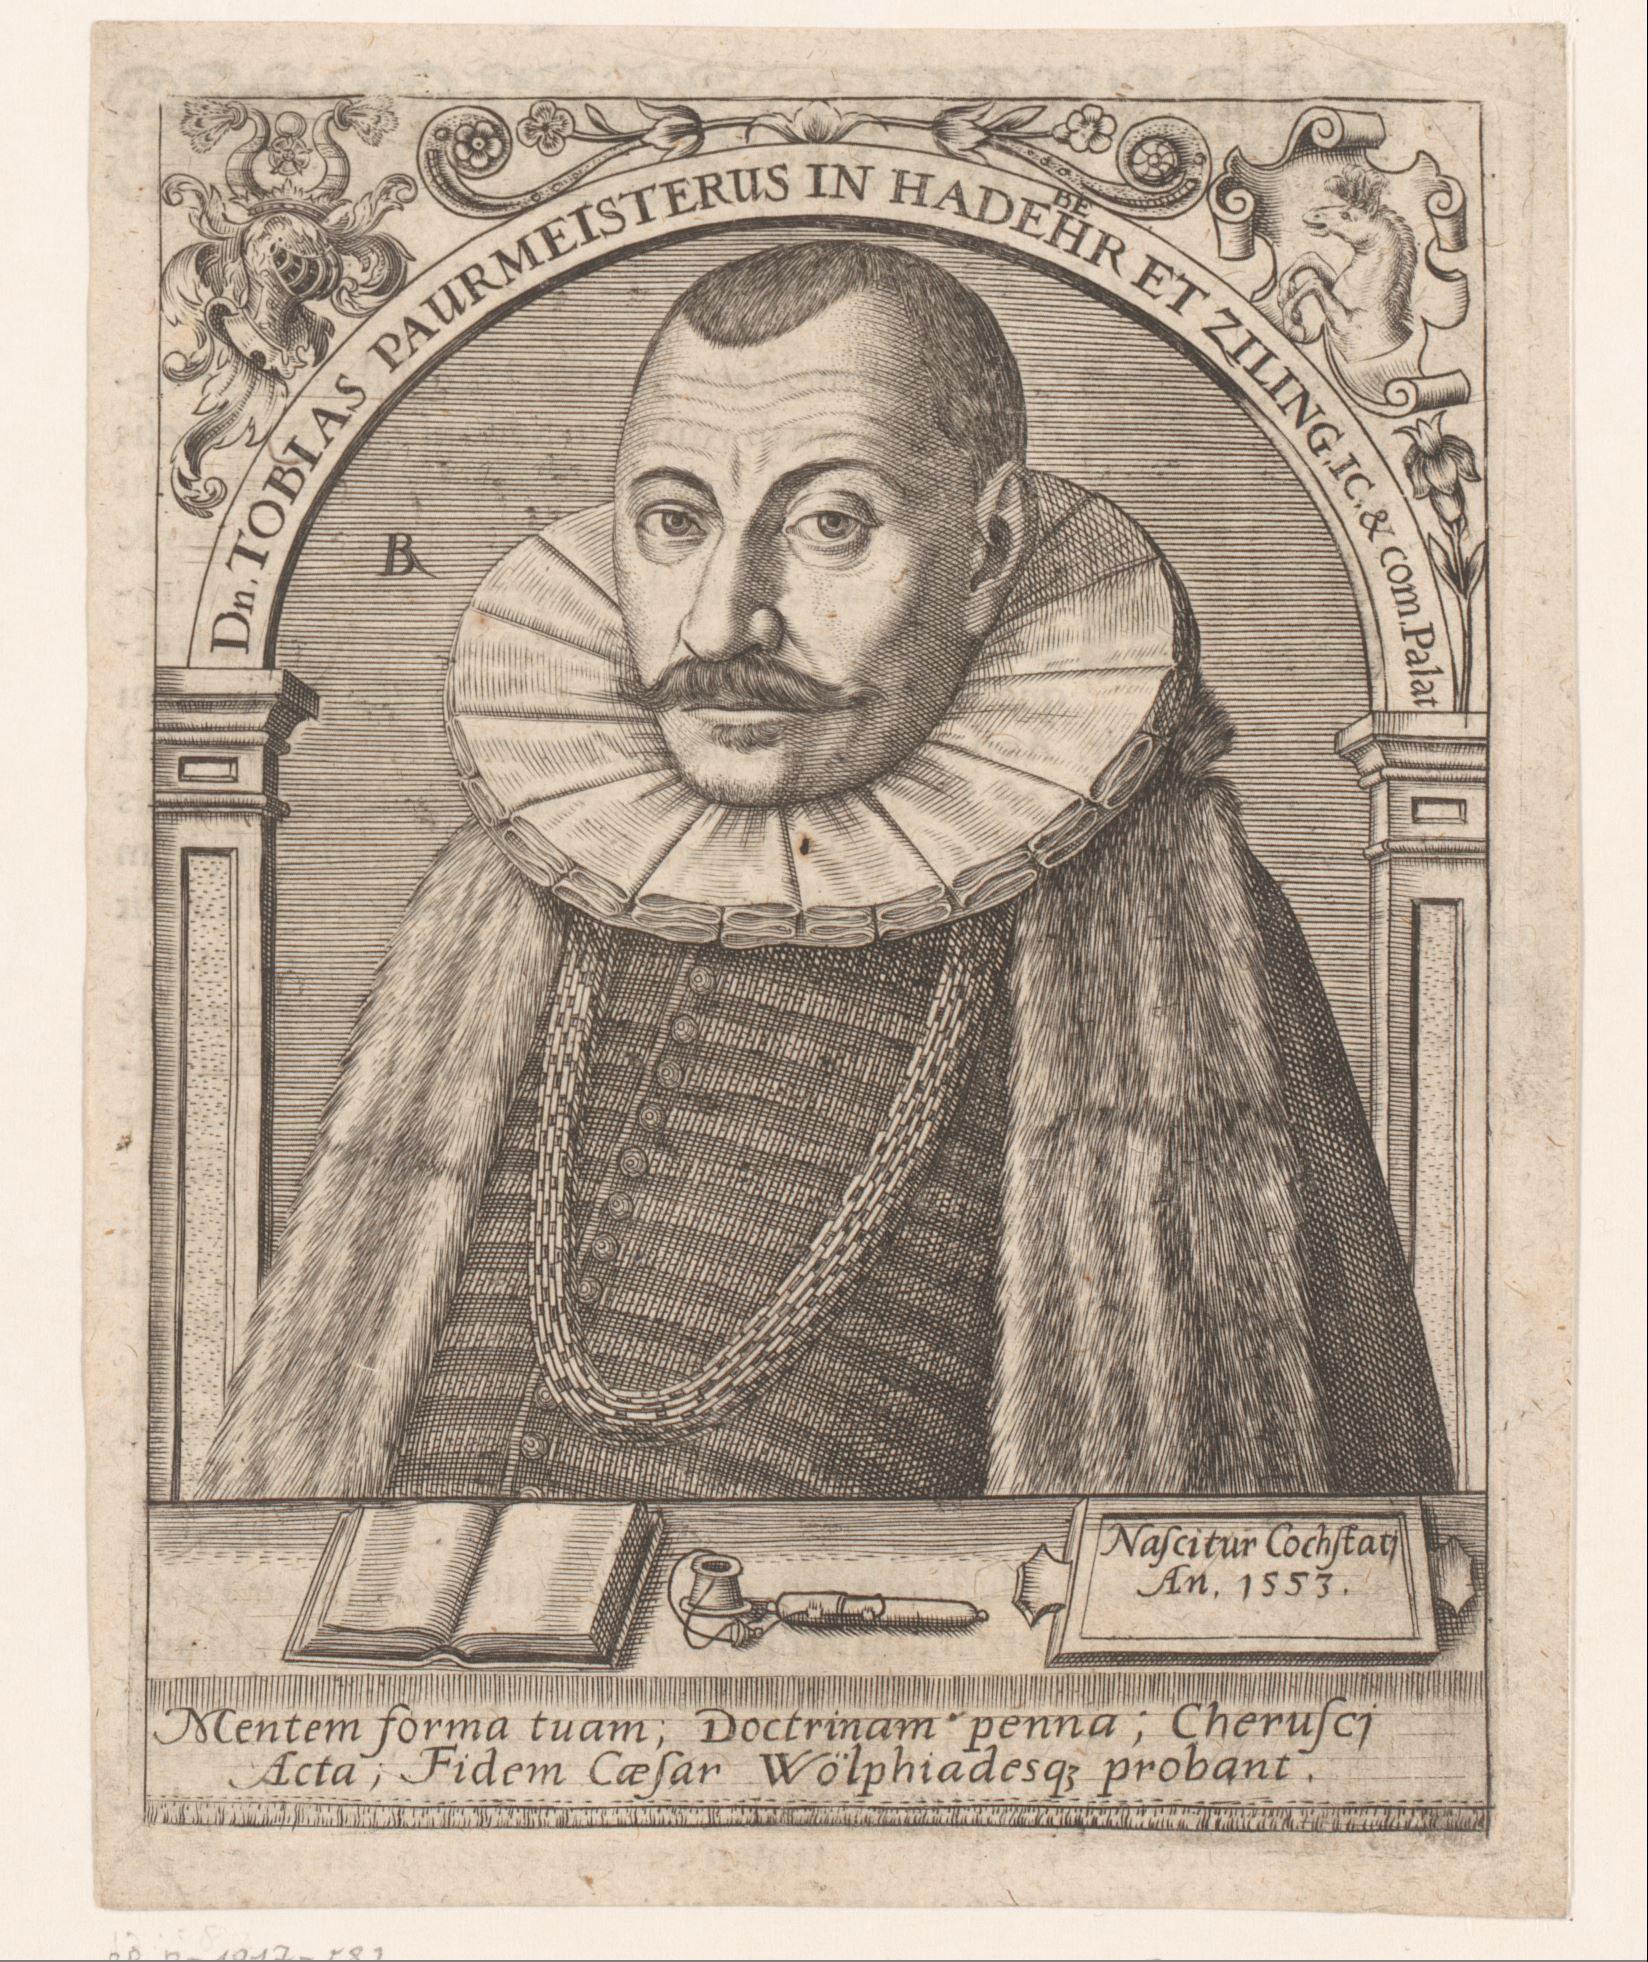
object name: book illustration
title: Dn. Tobias Paurmeisterus in Hadebehr et Ziling. IC. & com. Palat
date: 1597-1599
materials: paper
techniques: engraving, letterpress printing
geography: france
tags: ink-well, historical persons, book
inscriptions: collector's mark: Lugt 2228